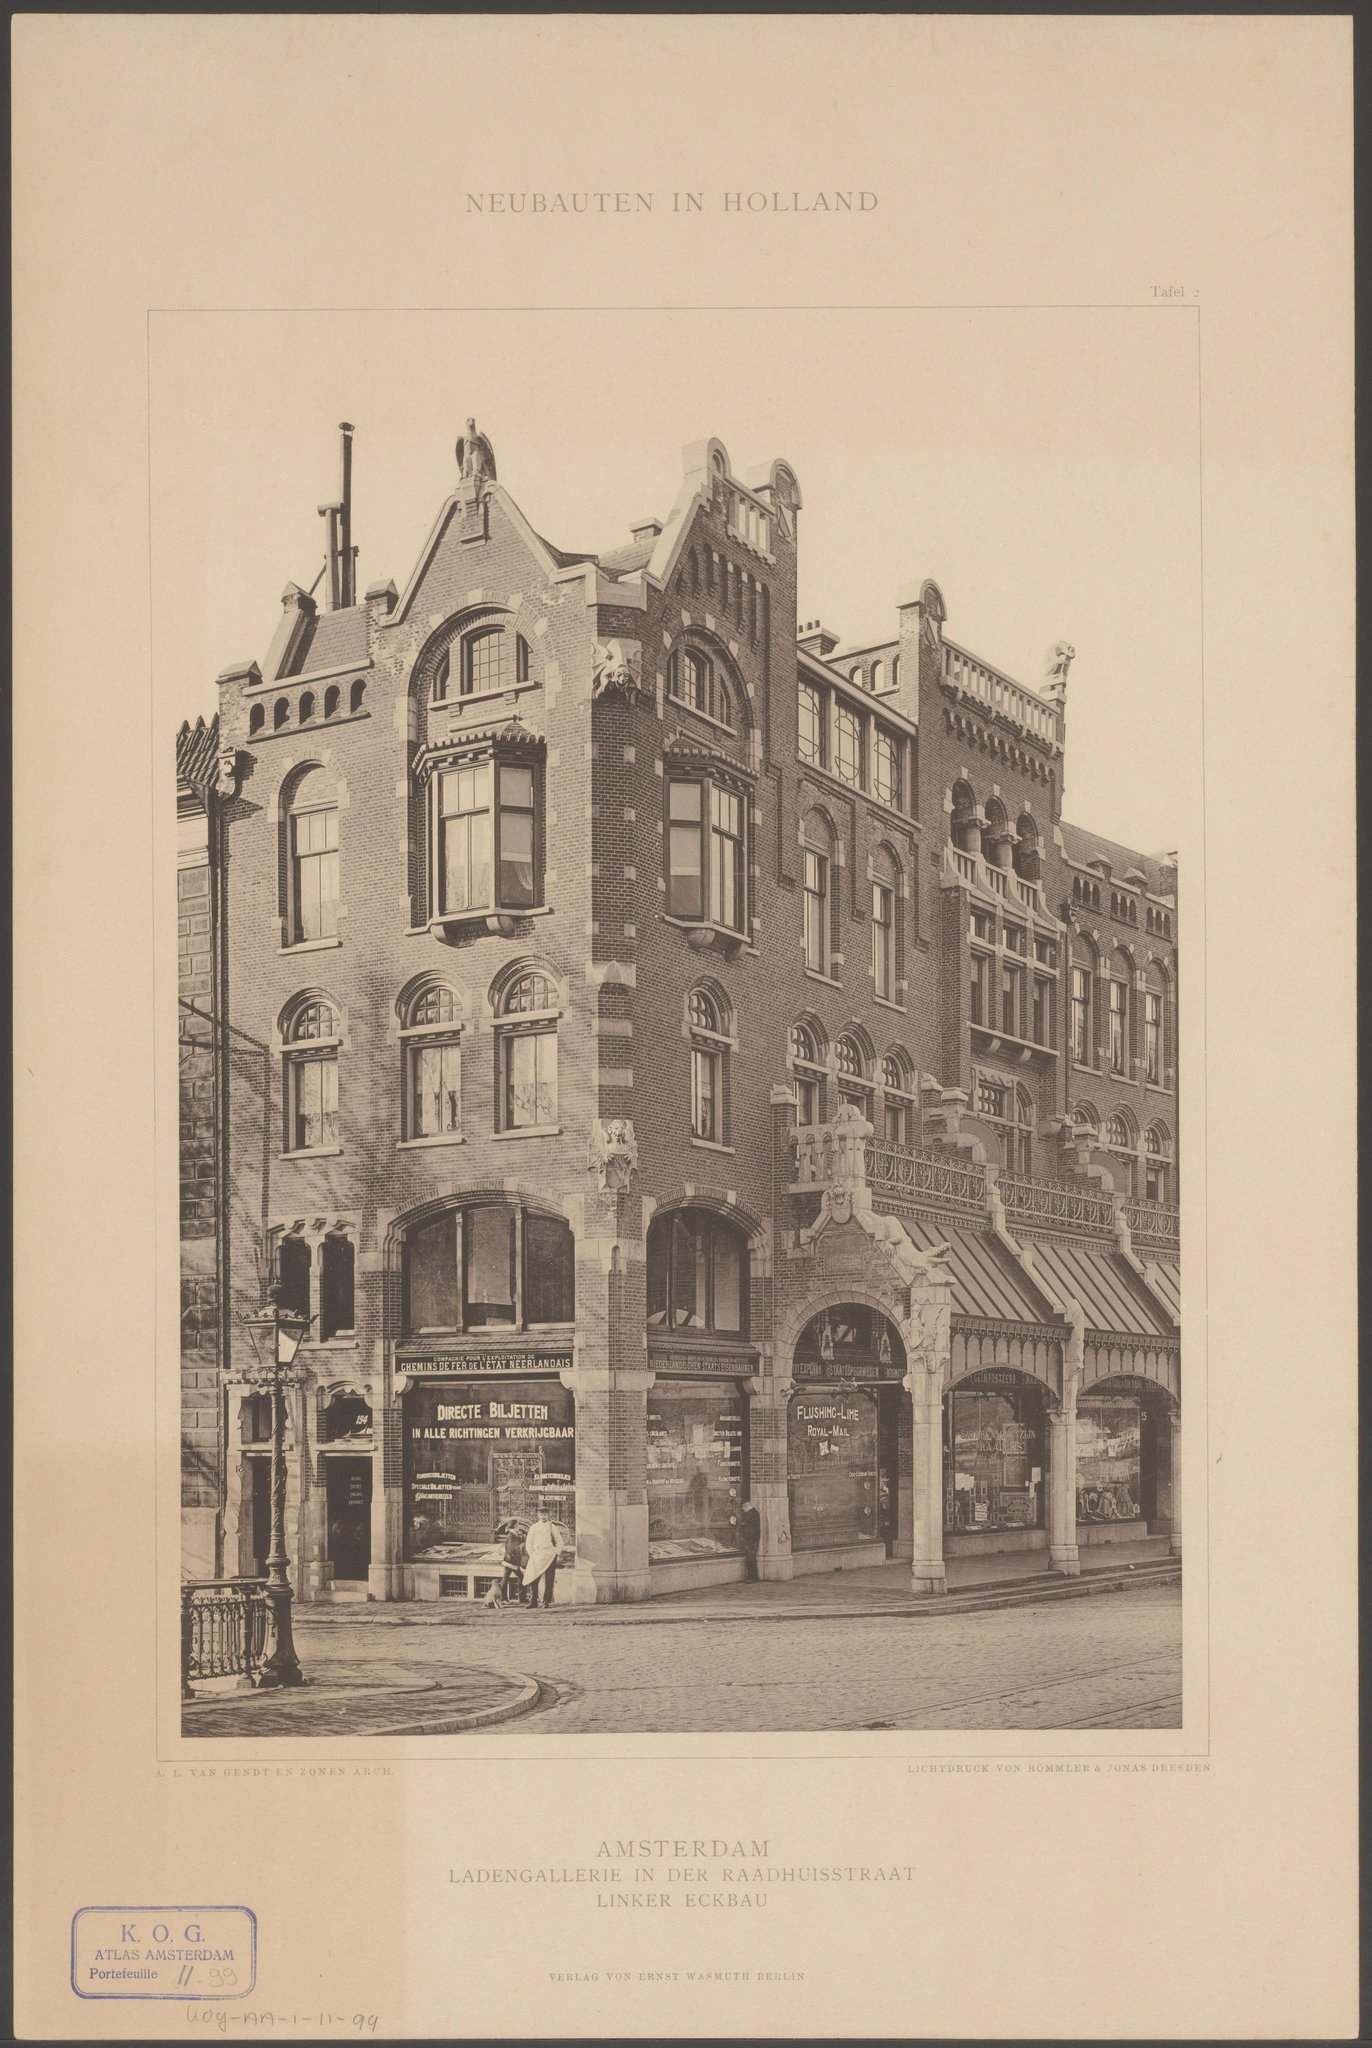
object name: photomechanical print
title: Gezicht op de winkelgalerij in de Raadhuisstraat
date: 1899-1945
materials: cardboard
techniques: photograph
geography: dresden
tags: city-view in general; 'veduta', gallery (spacious corridor), façade (of house or building), street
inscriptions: collector's mark: ‘11.99’ Lugt 1641b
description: Onderwerpsrubriek binnen de Atlas Amsterdam: Raadhuisstraat, Raamgracht, Raamplein, Rapenburgerstraat, Reguliersgracht, Reguliersbreestraat.